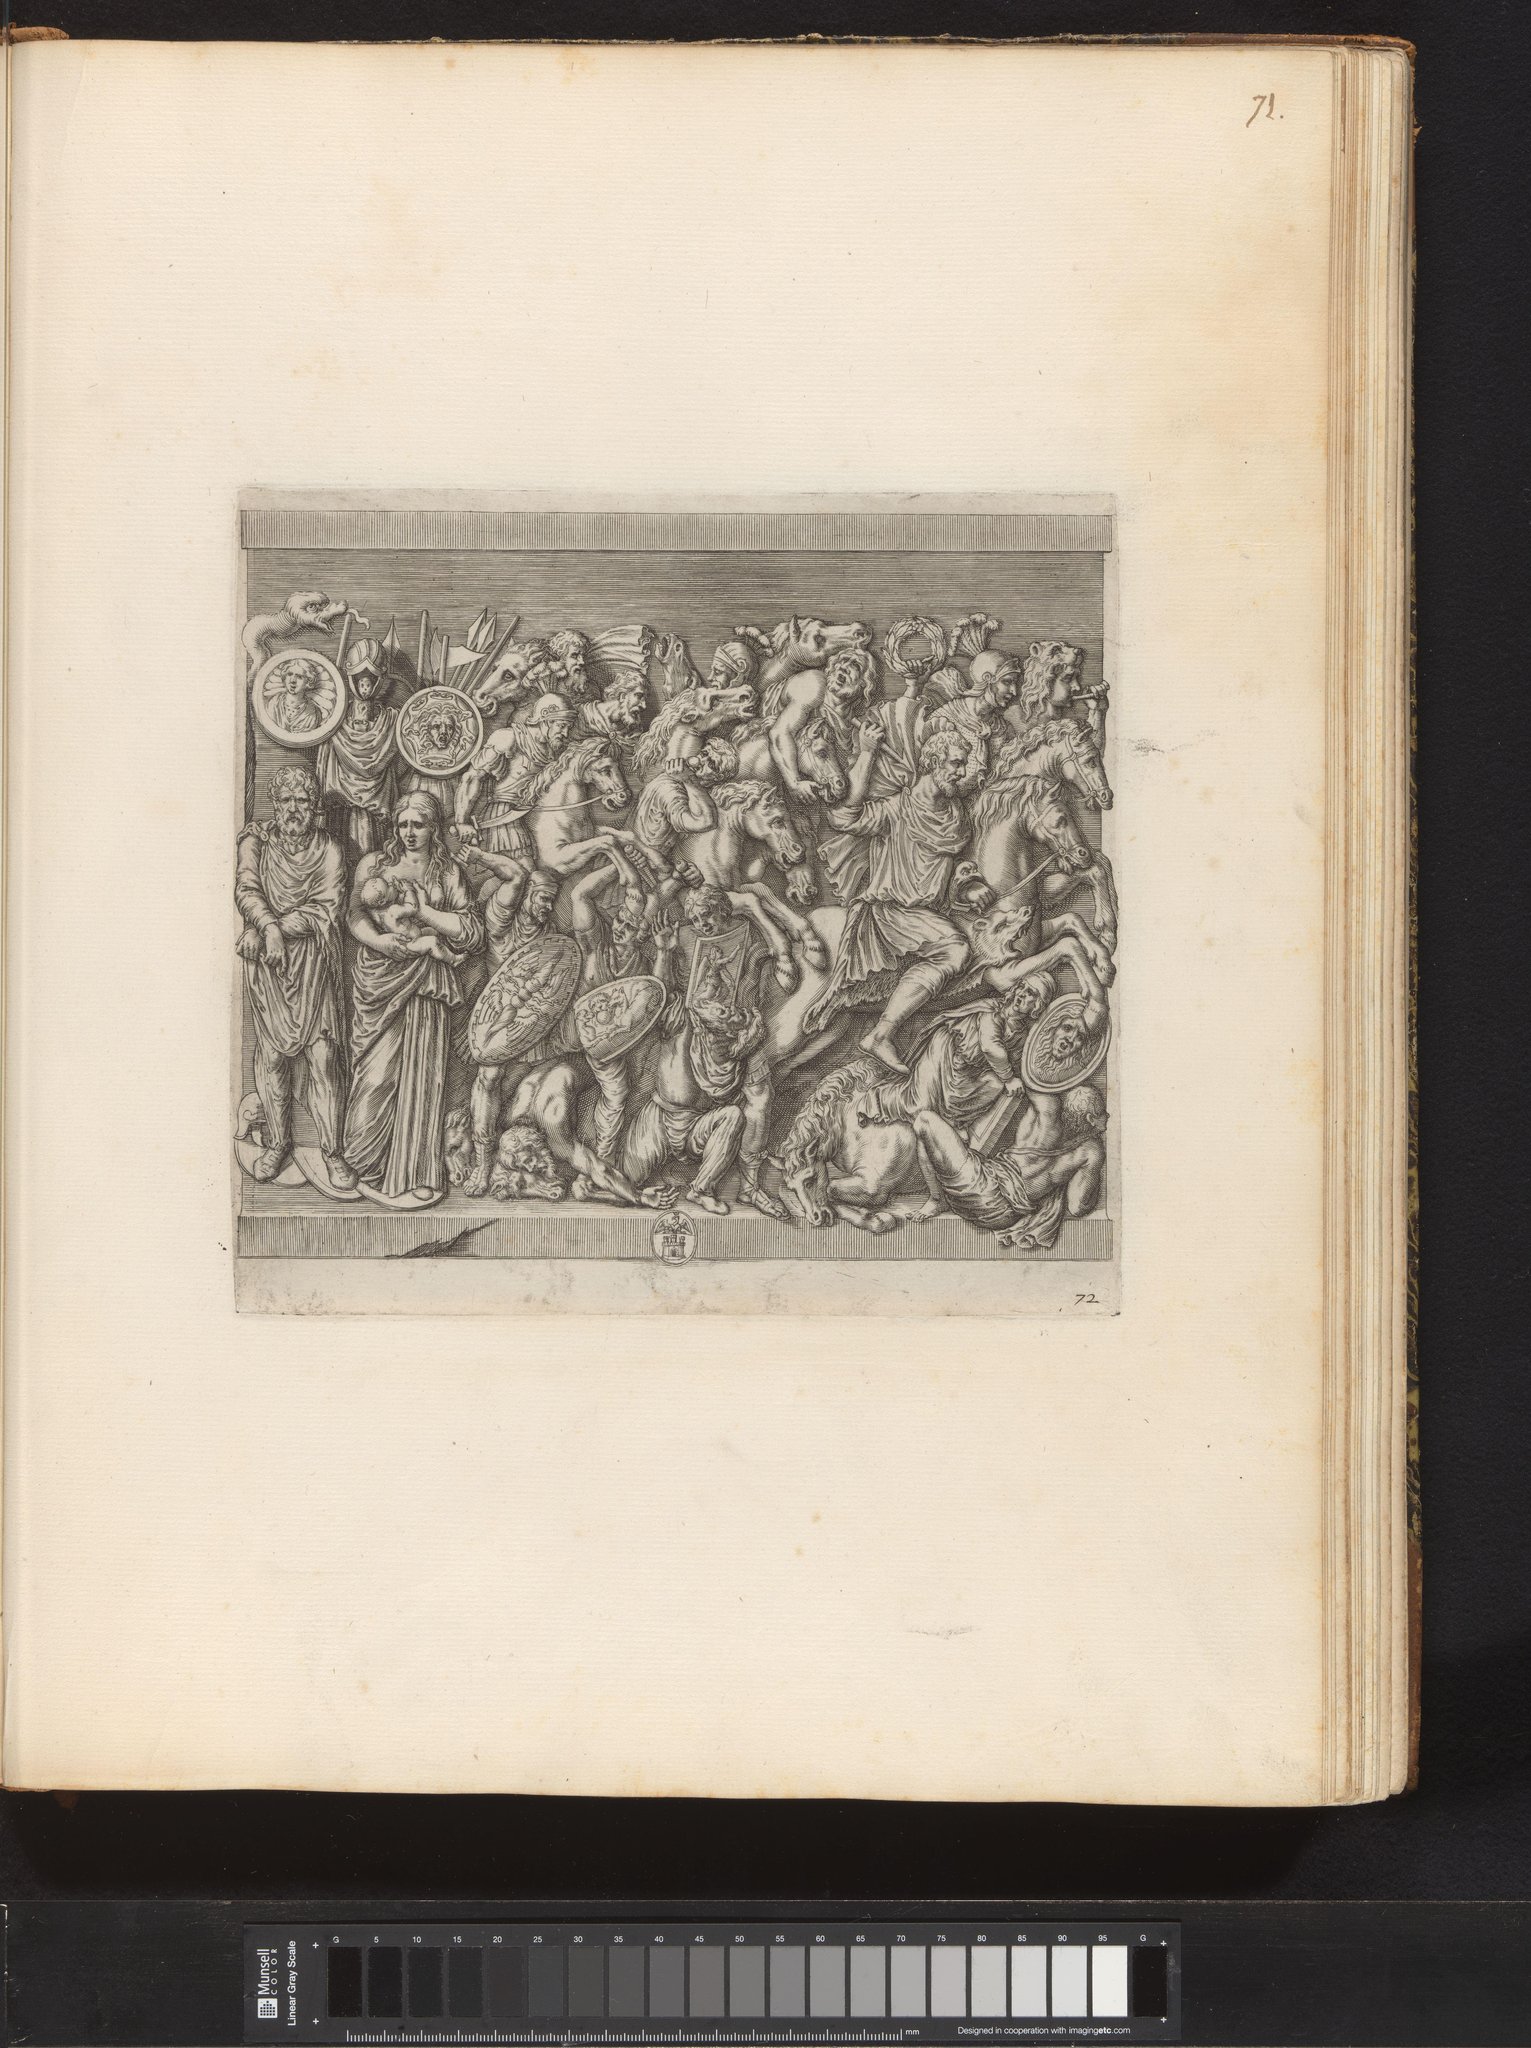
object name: print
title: Bas-reliëf met voorstelling van de jacht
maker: johann friedrich greuter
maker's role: print maker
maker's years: 1589-1662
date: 1636-1647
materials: paper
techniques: engraving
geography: rome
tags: hunting, chase, boar-hunting, piece of sculpture, reproduction of a piece of sculpture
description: Bas-reliëf met voorstelling van de jacht. Een man staat op het punt een wild zwijn met zijn speer te doden. Een man toont een geschoten hert. Midden onder het wapenschild van Vincenzo Giustiniani. Prent maakt deel uit van een album met een serie prenten naar de sculpturen in de verzameling in de Galleria Giustiniani te Rome.